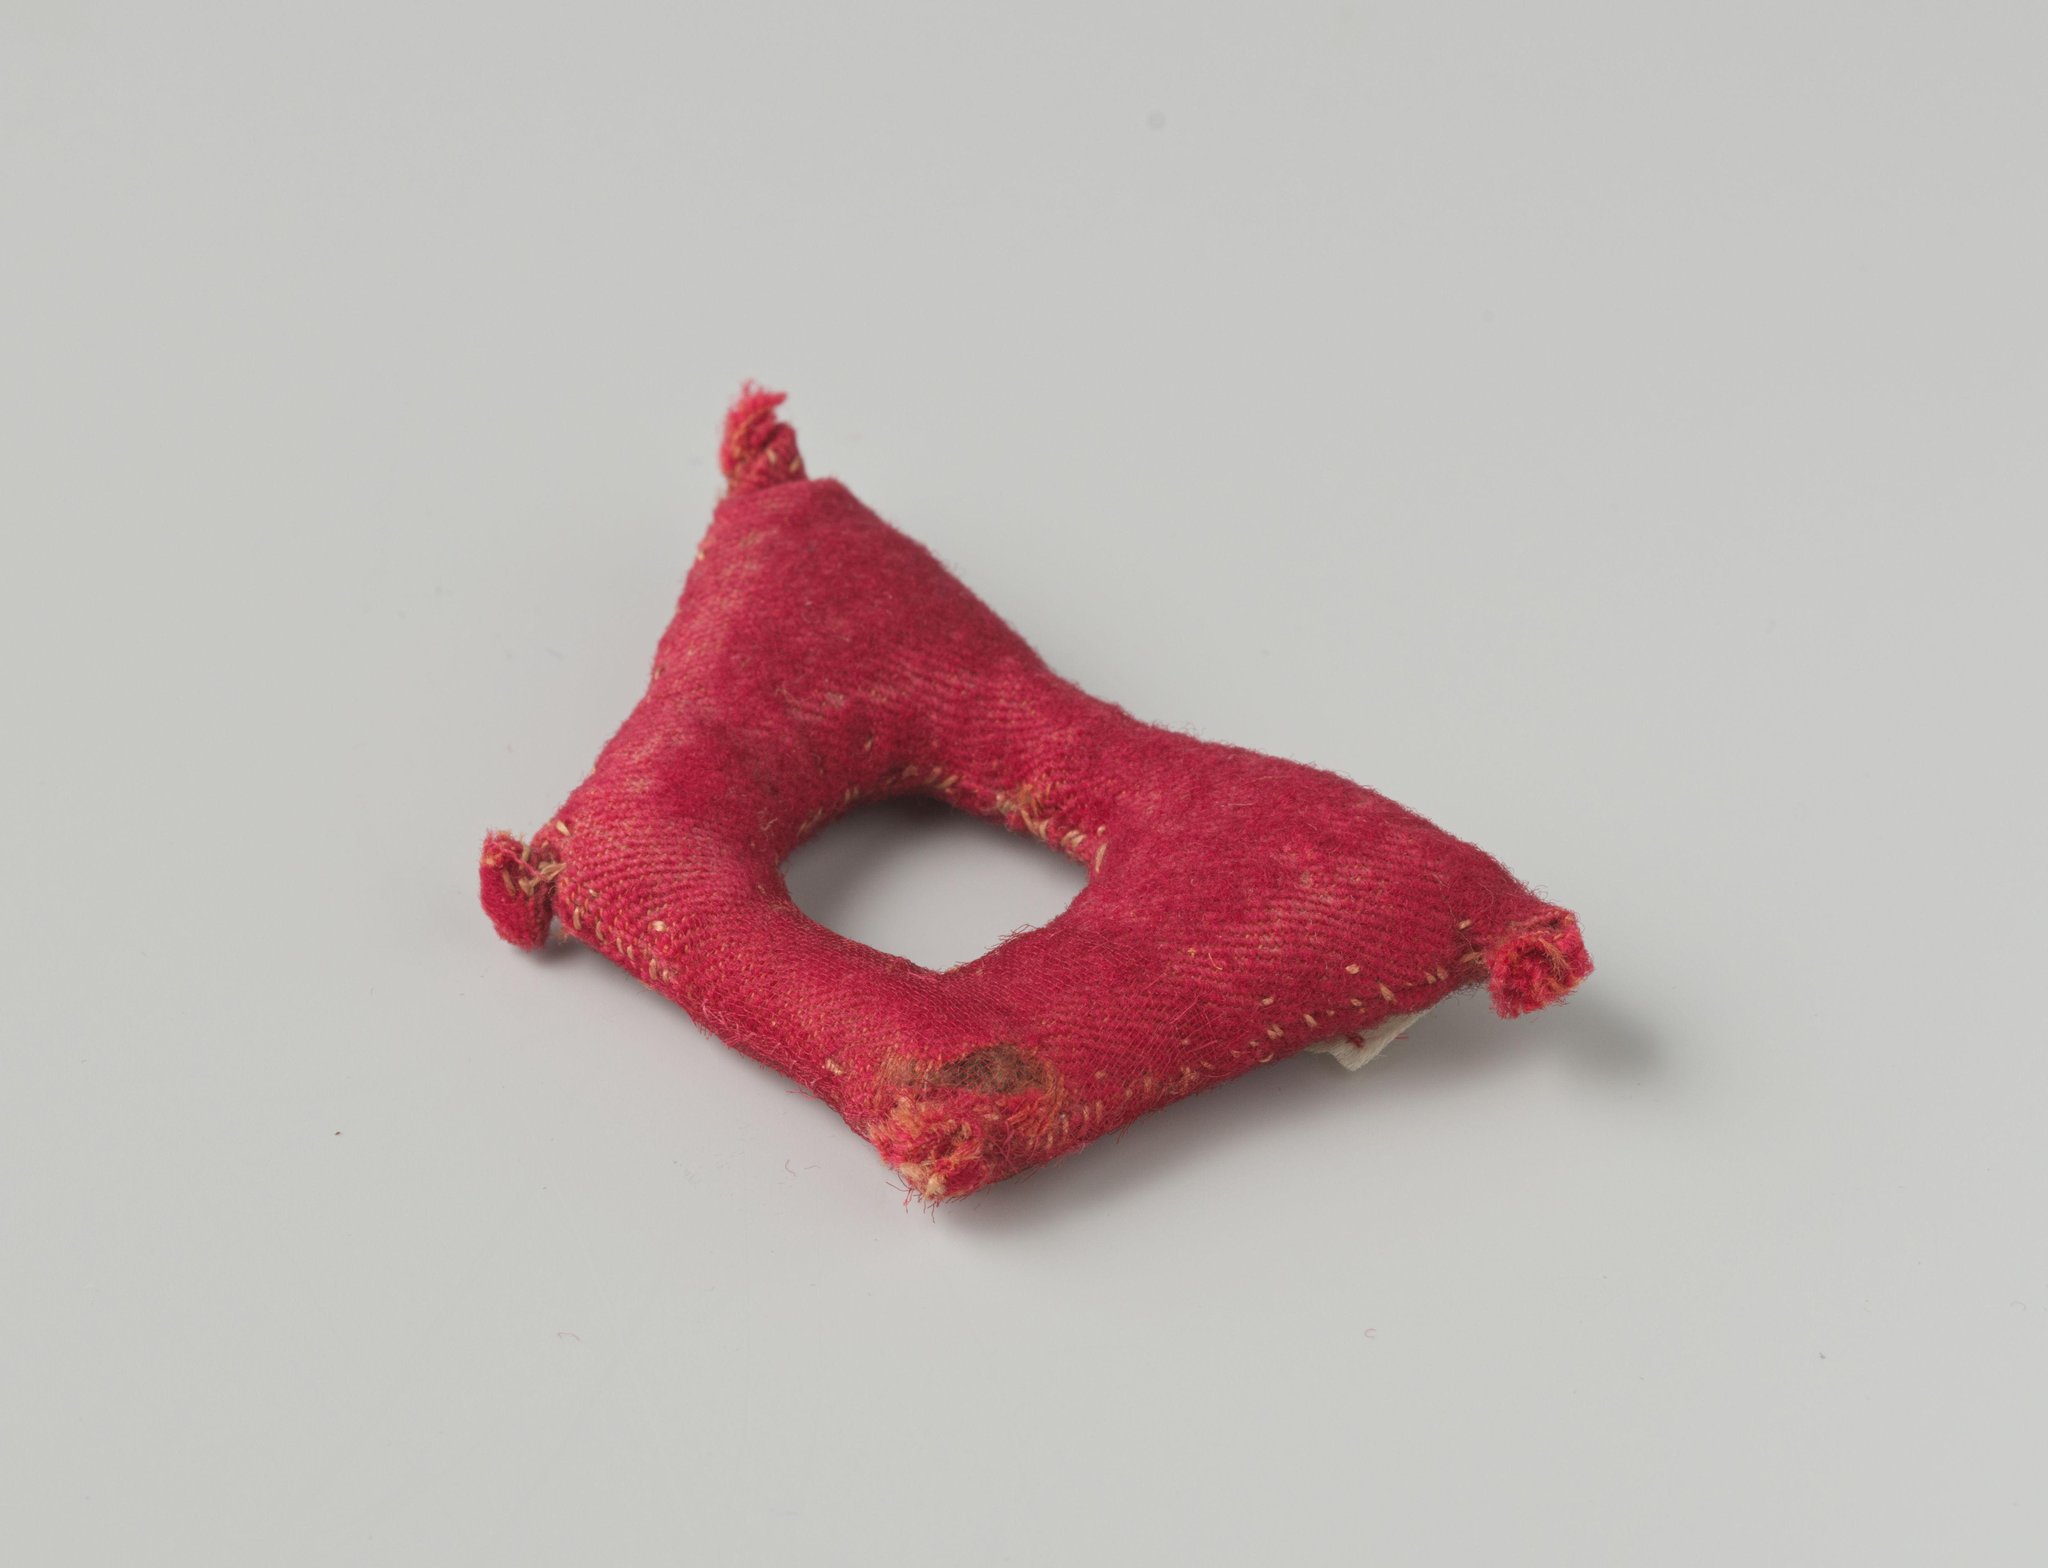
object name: miniature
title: Rugkussen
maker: Anonymous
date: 1690-1710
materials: down, silk, wool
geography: amsterdam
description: Rugkussen, passend in de kinderkakstoel; vervaardigd van een rode geruwde stof (half zijde / half wol). Het boogvormige kussen is dun gevuld, gecapitonneerd een door gepit met geelgroene zijde kwastjes.